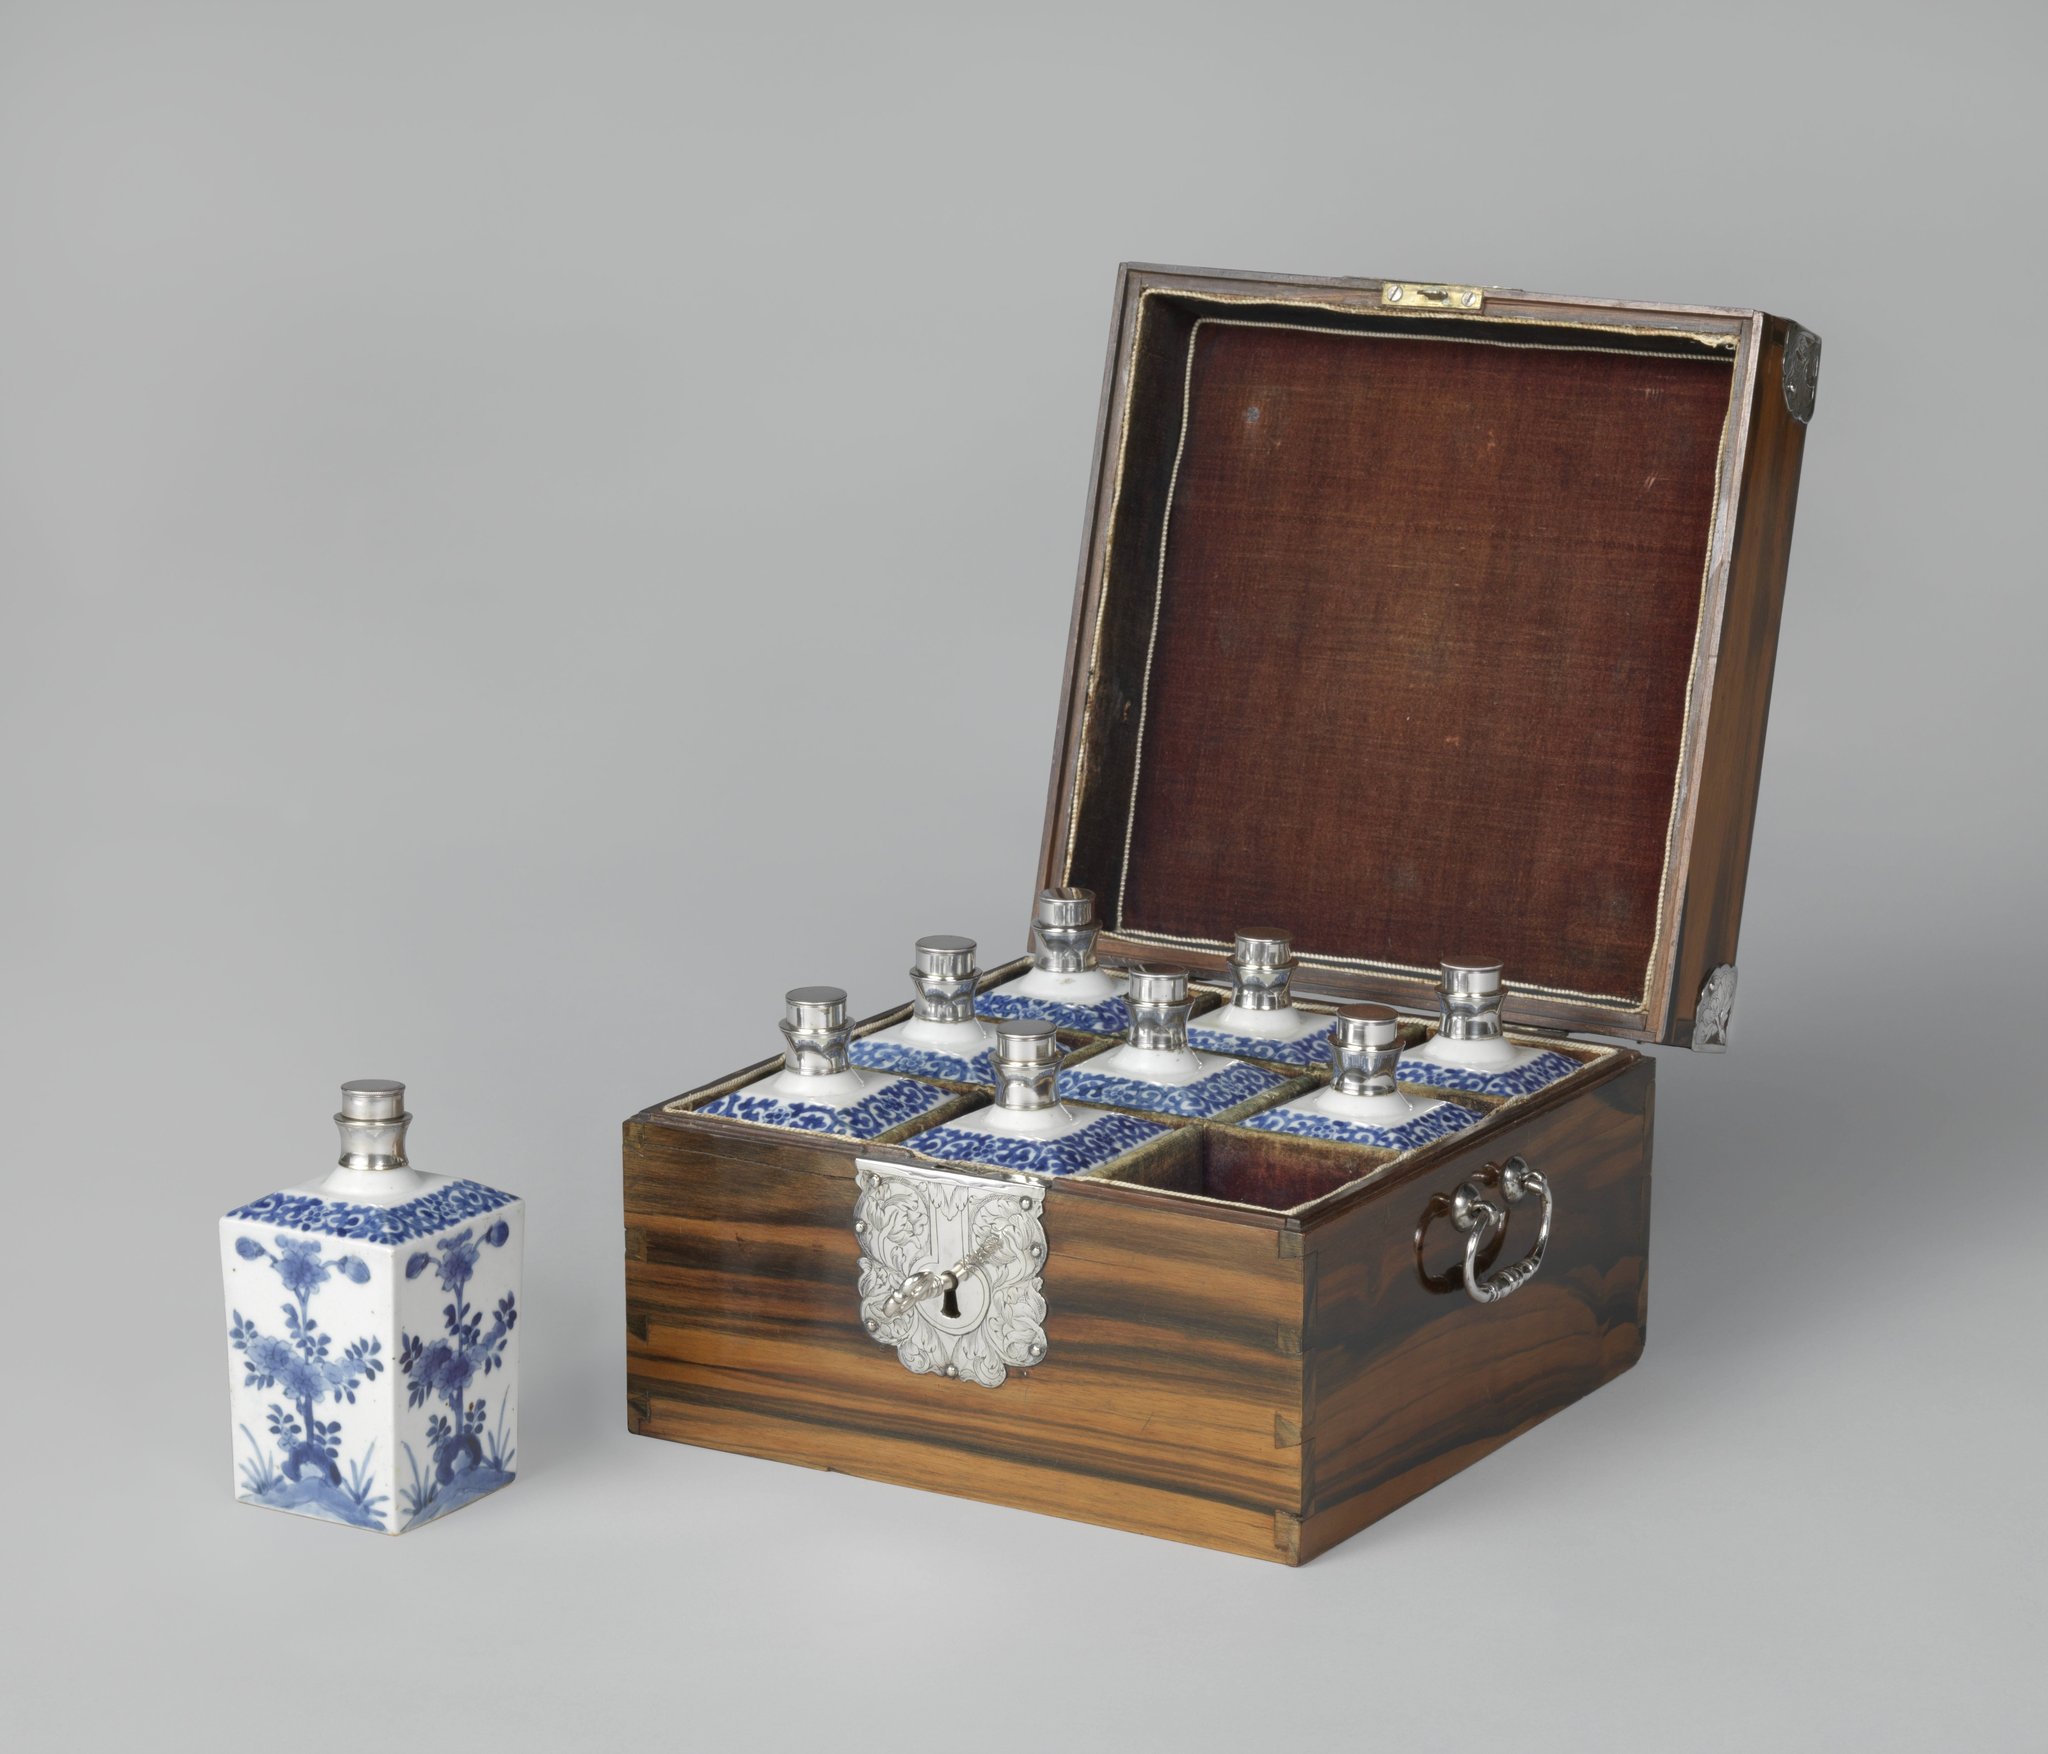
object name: bottle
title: Chest with nine bottles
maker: Anonymous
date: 1680-1700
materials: wood, porcelain, silver, velvet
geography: japan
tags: flowers, lotus ~ ornament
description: The Dutch East India Company maintained good relations with Asian rulers. To promote their commercial interests, they greased palms with presents: globes, paintings, animals, and chests with bottles, like this one. The expensive aromatic oils in the bottles were the actual gift. The bottles were ordered in Japan and the chest was custommade by joiners in Batavia.